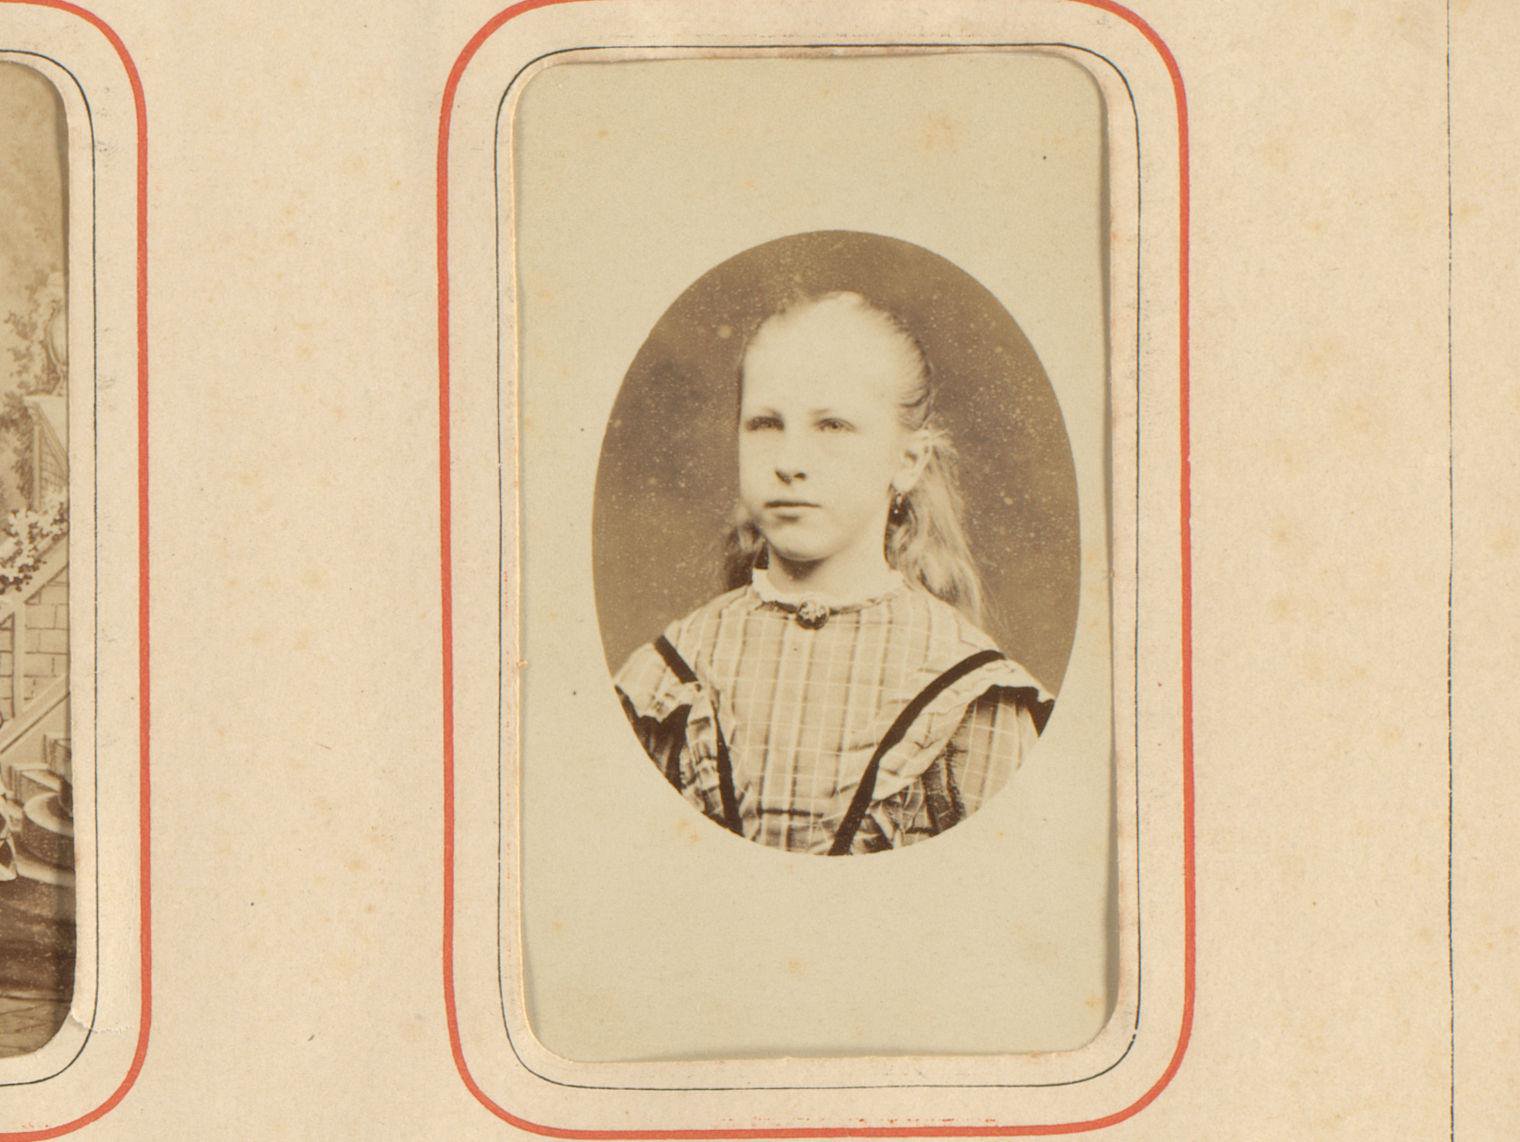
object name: photograph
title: Portret van een onbekend meisje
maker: pieter vlaanderen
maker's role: fotograaf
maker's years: 1840-1878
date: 1870-1878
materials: cardboard, paper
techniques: albumen print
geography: alkmaar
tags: anonymous historical person portrayed - bb - woman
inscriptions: address: ‘Verdronken Oord/ Wijk D. No 34./ ALKMAAR.’